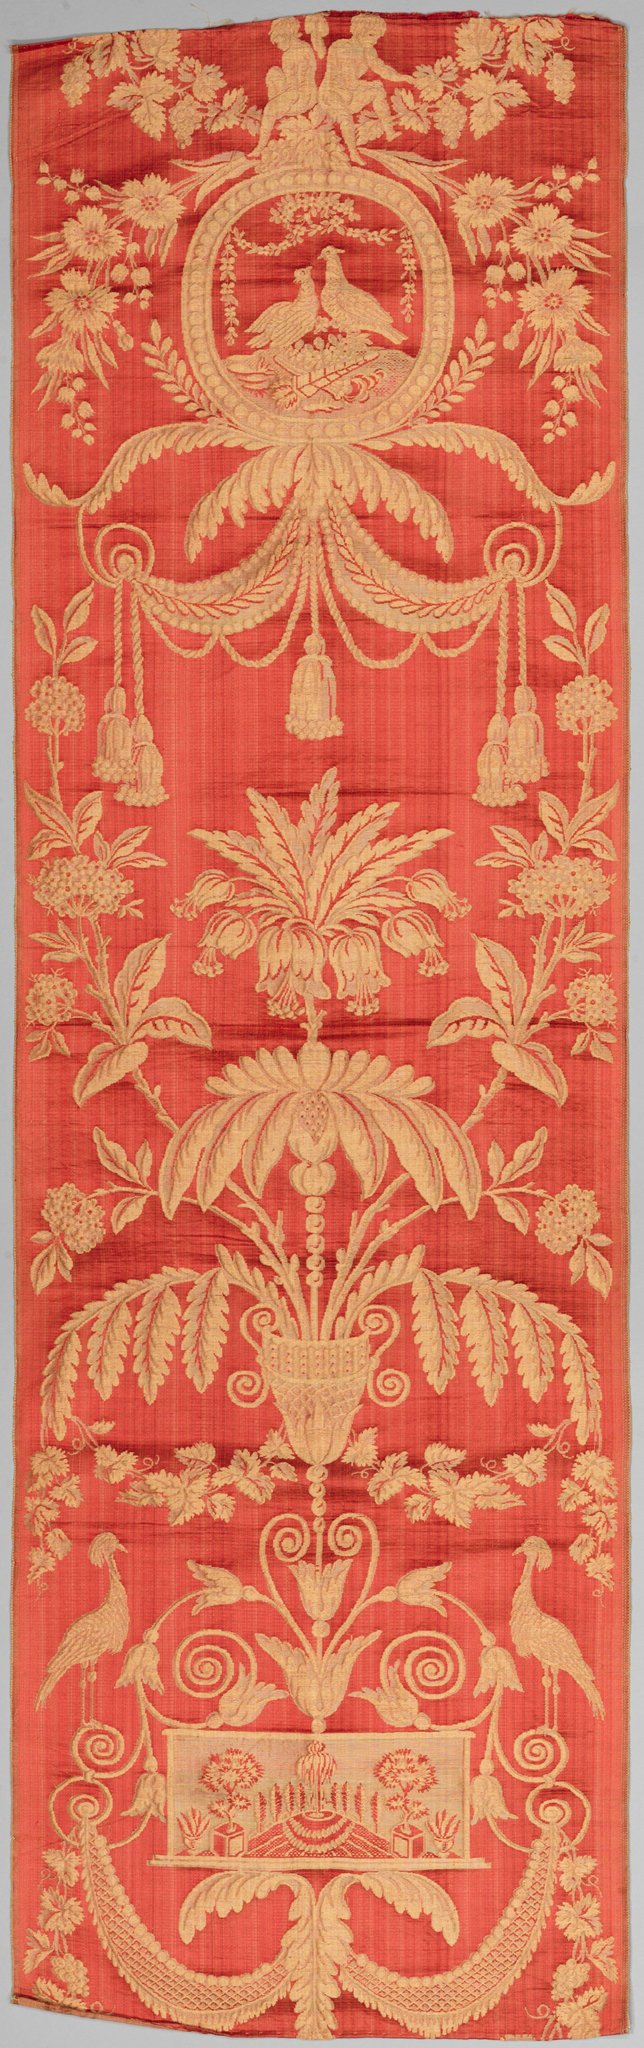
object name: silk textile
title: Baan Jacquardweefsel in satijnbinding met liseré-effect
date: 1920-1930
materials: silk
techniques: jacquard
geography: france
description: Baan Jacquardweefsel in satijnbinding met liseré-effect. Dessin: gestapeld ornament, van boven naar onder van twee ruggelings gespiegelde putti met wijnranken, twee duiven in medaillons, waarvan koorden met kwasten en bladeren afhangen. Een korf waaruit een arrangement van bloemen en bladeren omhoog rijst en aan de onderzijde een guirlande van wijnranken, een rechthoekige cartouche waarin een tuin met fontein, bomen en gepotte bloemen en planten, omgeven door spiralende bladranken waarop links en rechts een (paradijs?)vogel, aan de onderzijde gesteund door een lambrequin met in het midden bladeren en aan de zijde, wijnranken en druiven, in twee tinten beige/groen op een ceriserood fond. Het dessin gaat terug op dat van Franse zijdeweefsels uit c. 1780. Aan de zelfkanten tweemaal gestempeld met het nummer: 43460/8. Opgespeld briefje (ca. 1978-1990) met de letters AP.